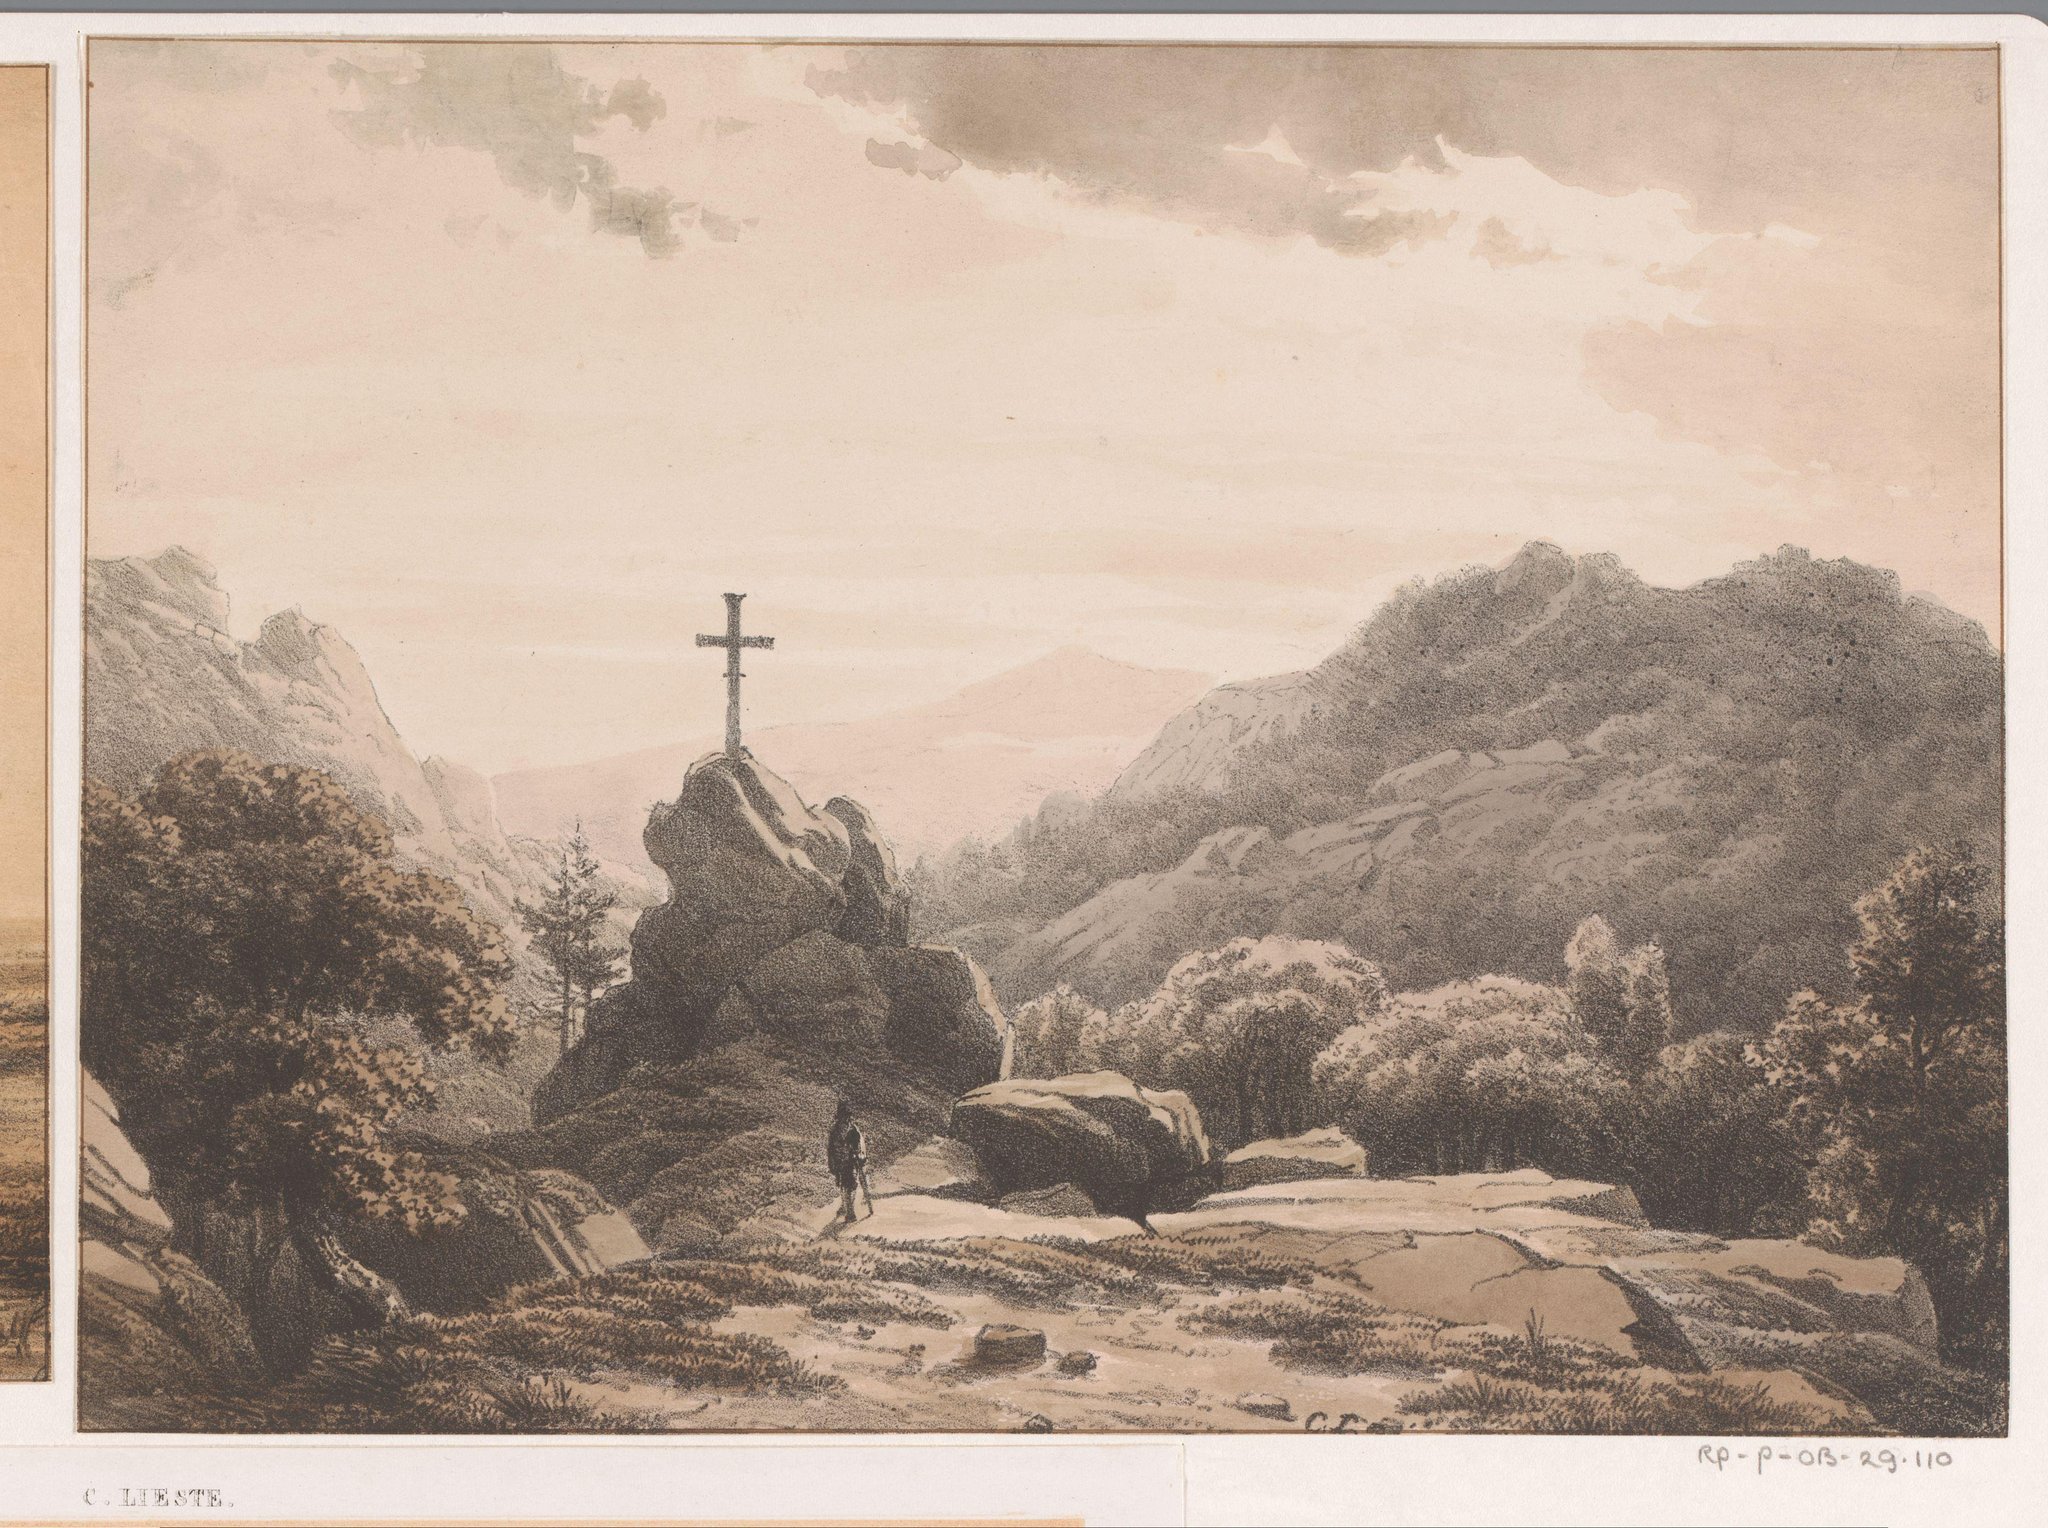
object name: print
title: Berglandschap met kruis op een rots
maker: cornelis lieste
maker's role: draughtsman, print maker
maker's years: 1817-1861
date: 1827-1861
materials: paper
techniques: hand coloring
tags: cross as symbol of christ, 'en route', traveller under way, mountains